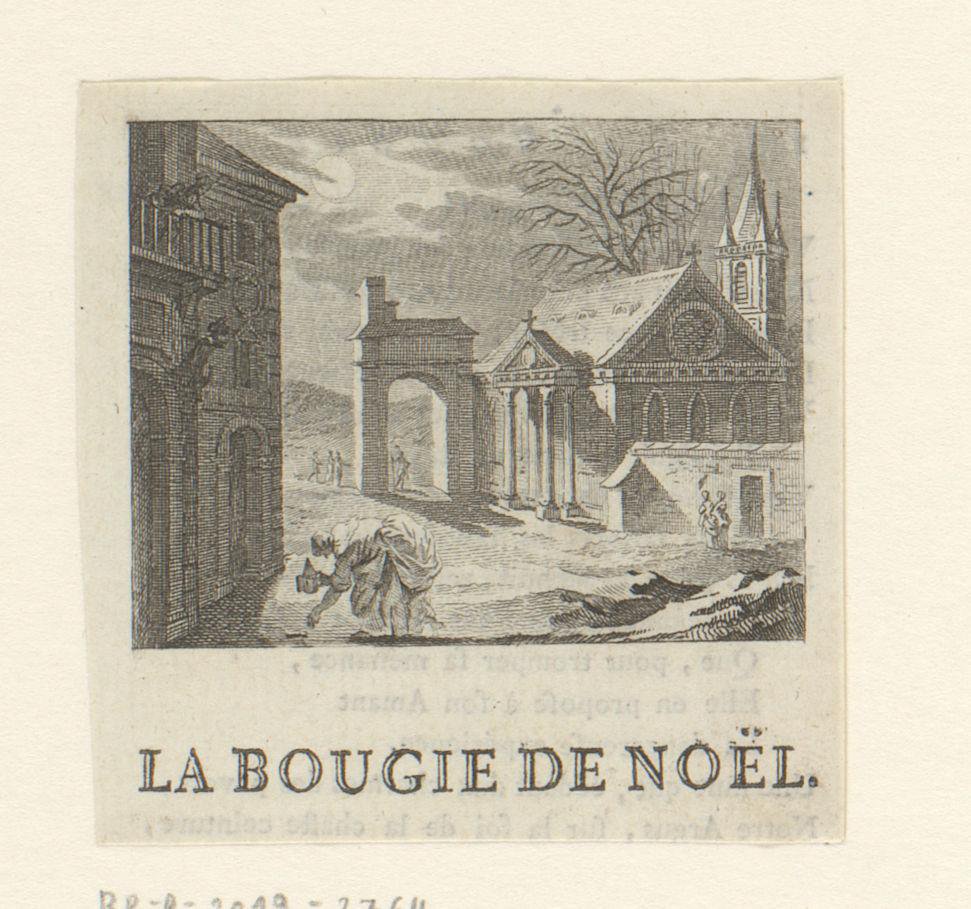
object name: print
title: Winters gezicht op een kerk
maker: Anonymous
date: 1763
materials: paper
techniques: engraving, etching, letterpress printing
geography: france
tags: winter, 'hyems'; 'inverno' (ripa), church (exterior), candle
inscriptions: collector's mark: Lugt 2228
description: Mogelijk prent uit: Grecourt, Jean Baptiste Joseph Willart de. Oeuvres diverses de M. de Grécourt, nouvelle édition, augmentée d'un grand nombre de pièces, revus sur les originales et du Philotanis. Amsterdam: s.n., 1763.